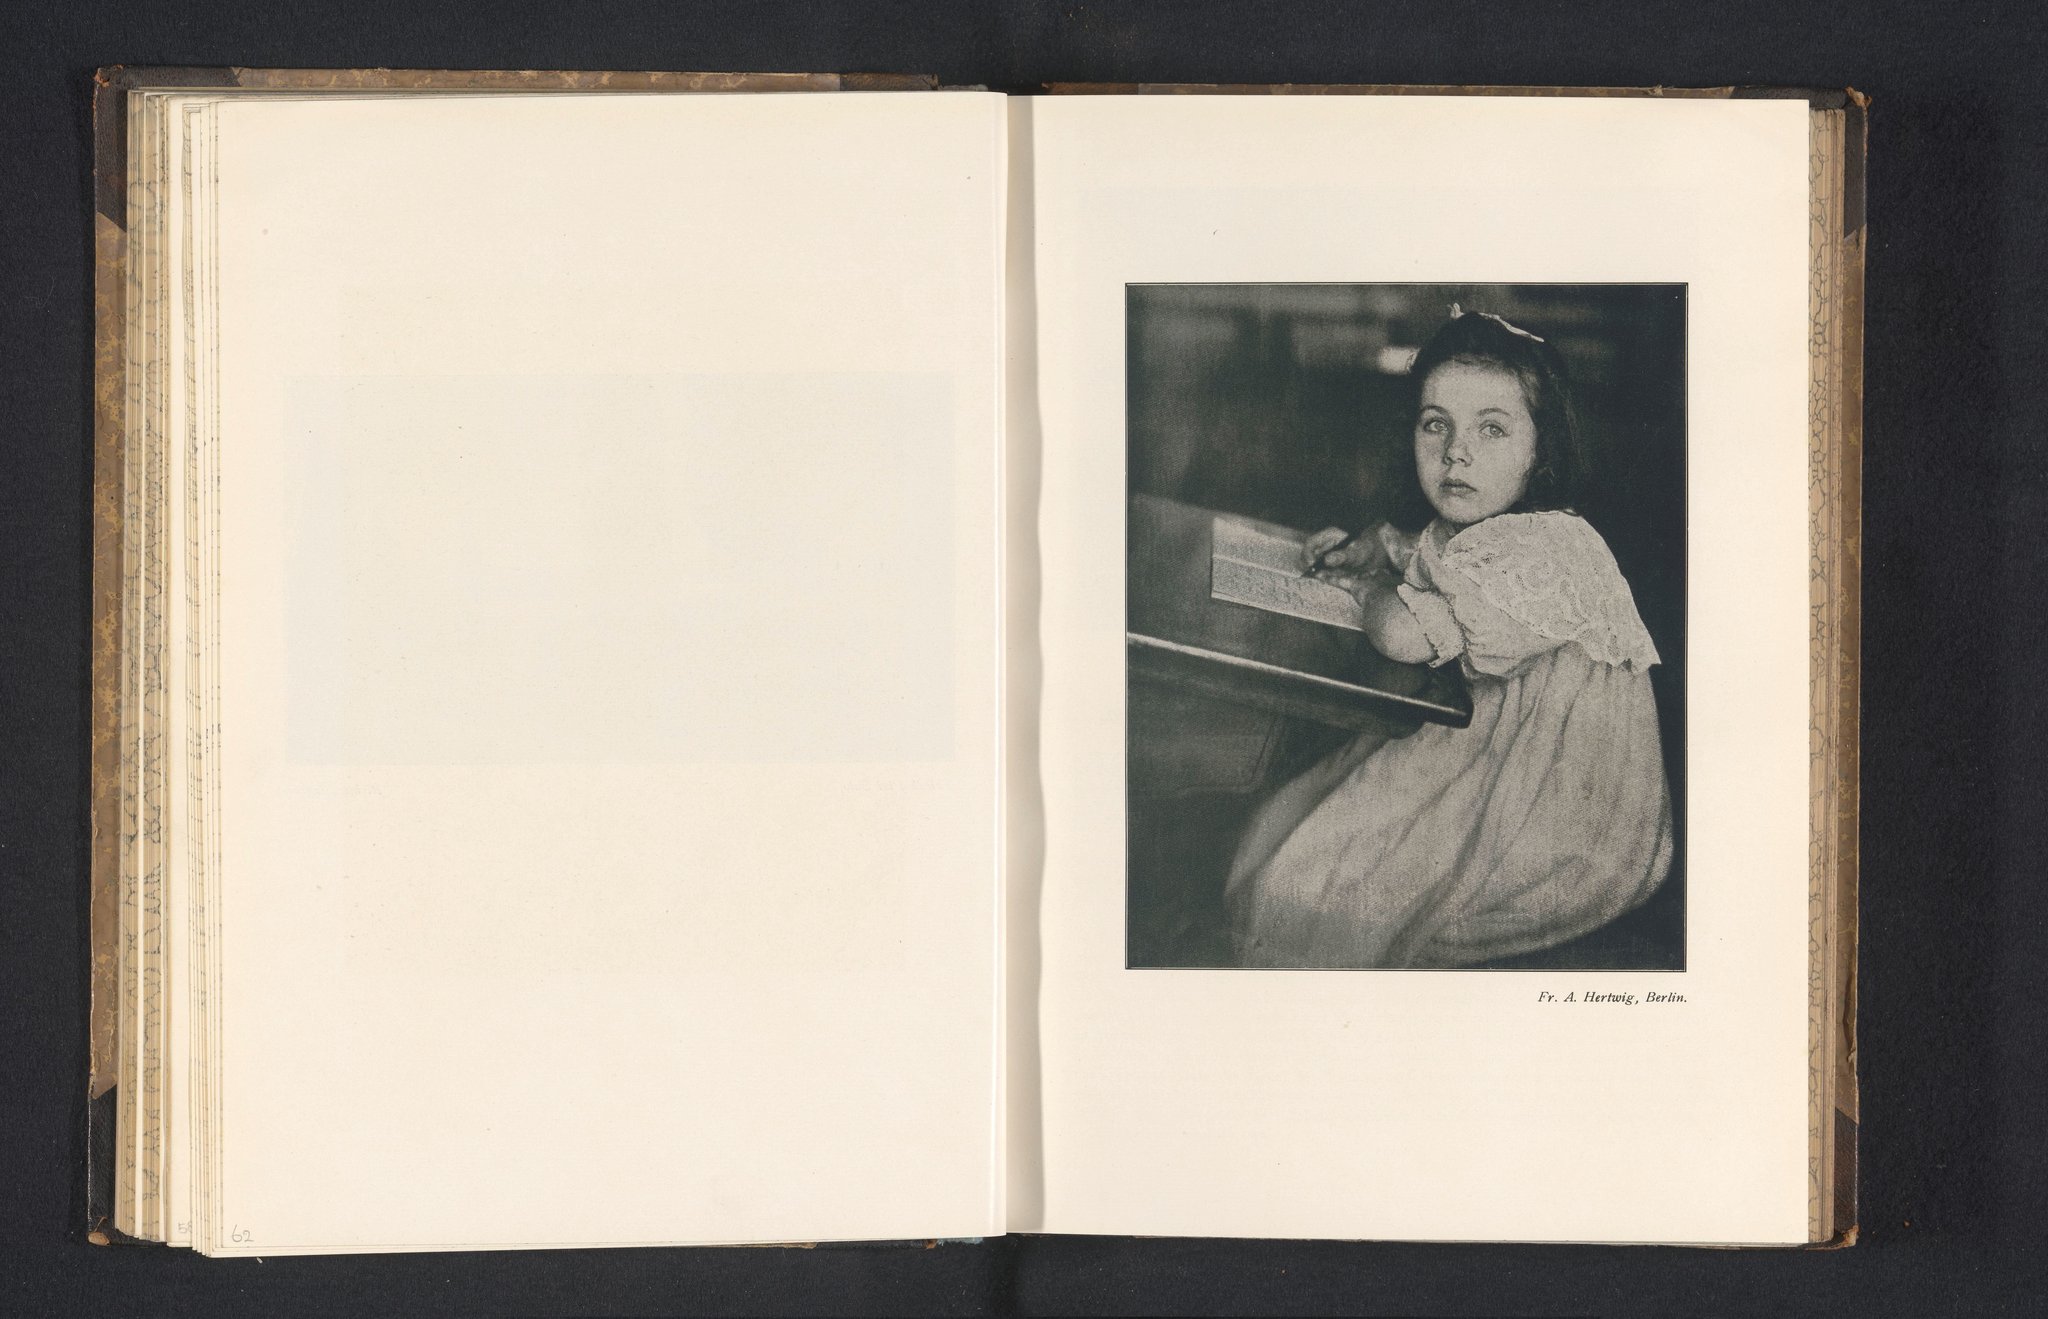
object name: page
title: Portret van een onbekend meisje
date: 1898-1903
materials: paper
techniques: autotype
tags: historical persons not known by name - bb - woman, girl (child between toddler and youth)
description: Prent op vierde ongenummerde pagina na pagina 108.